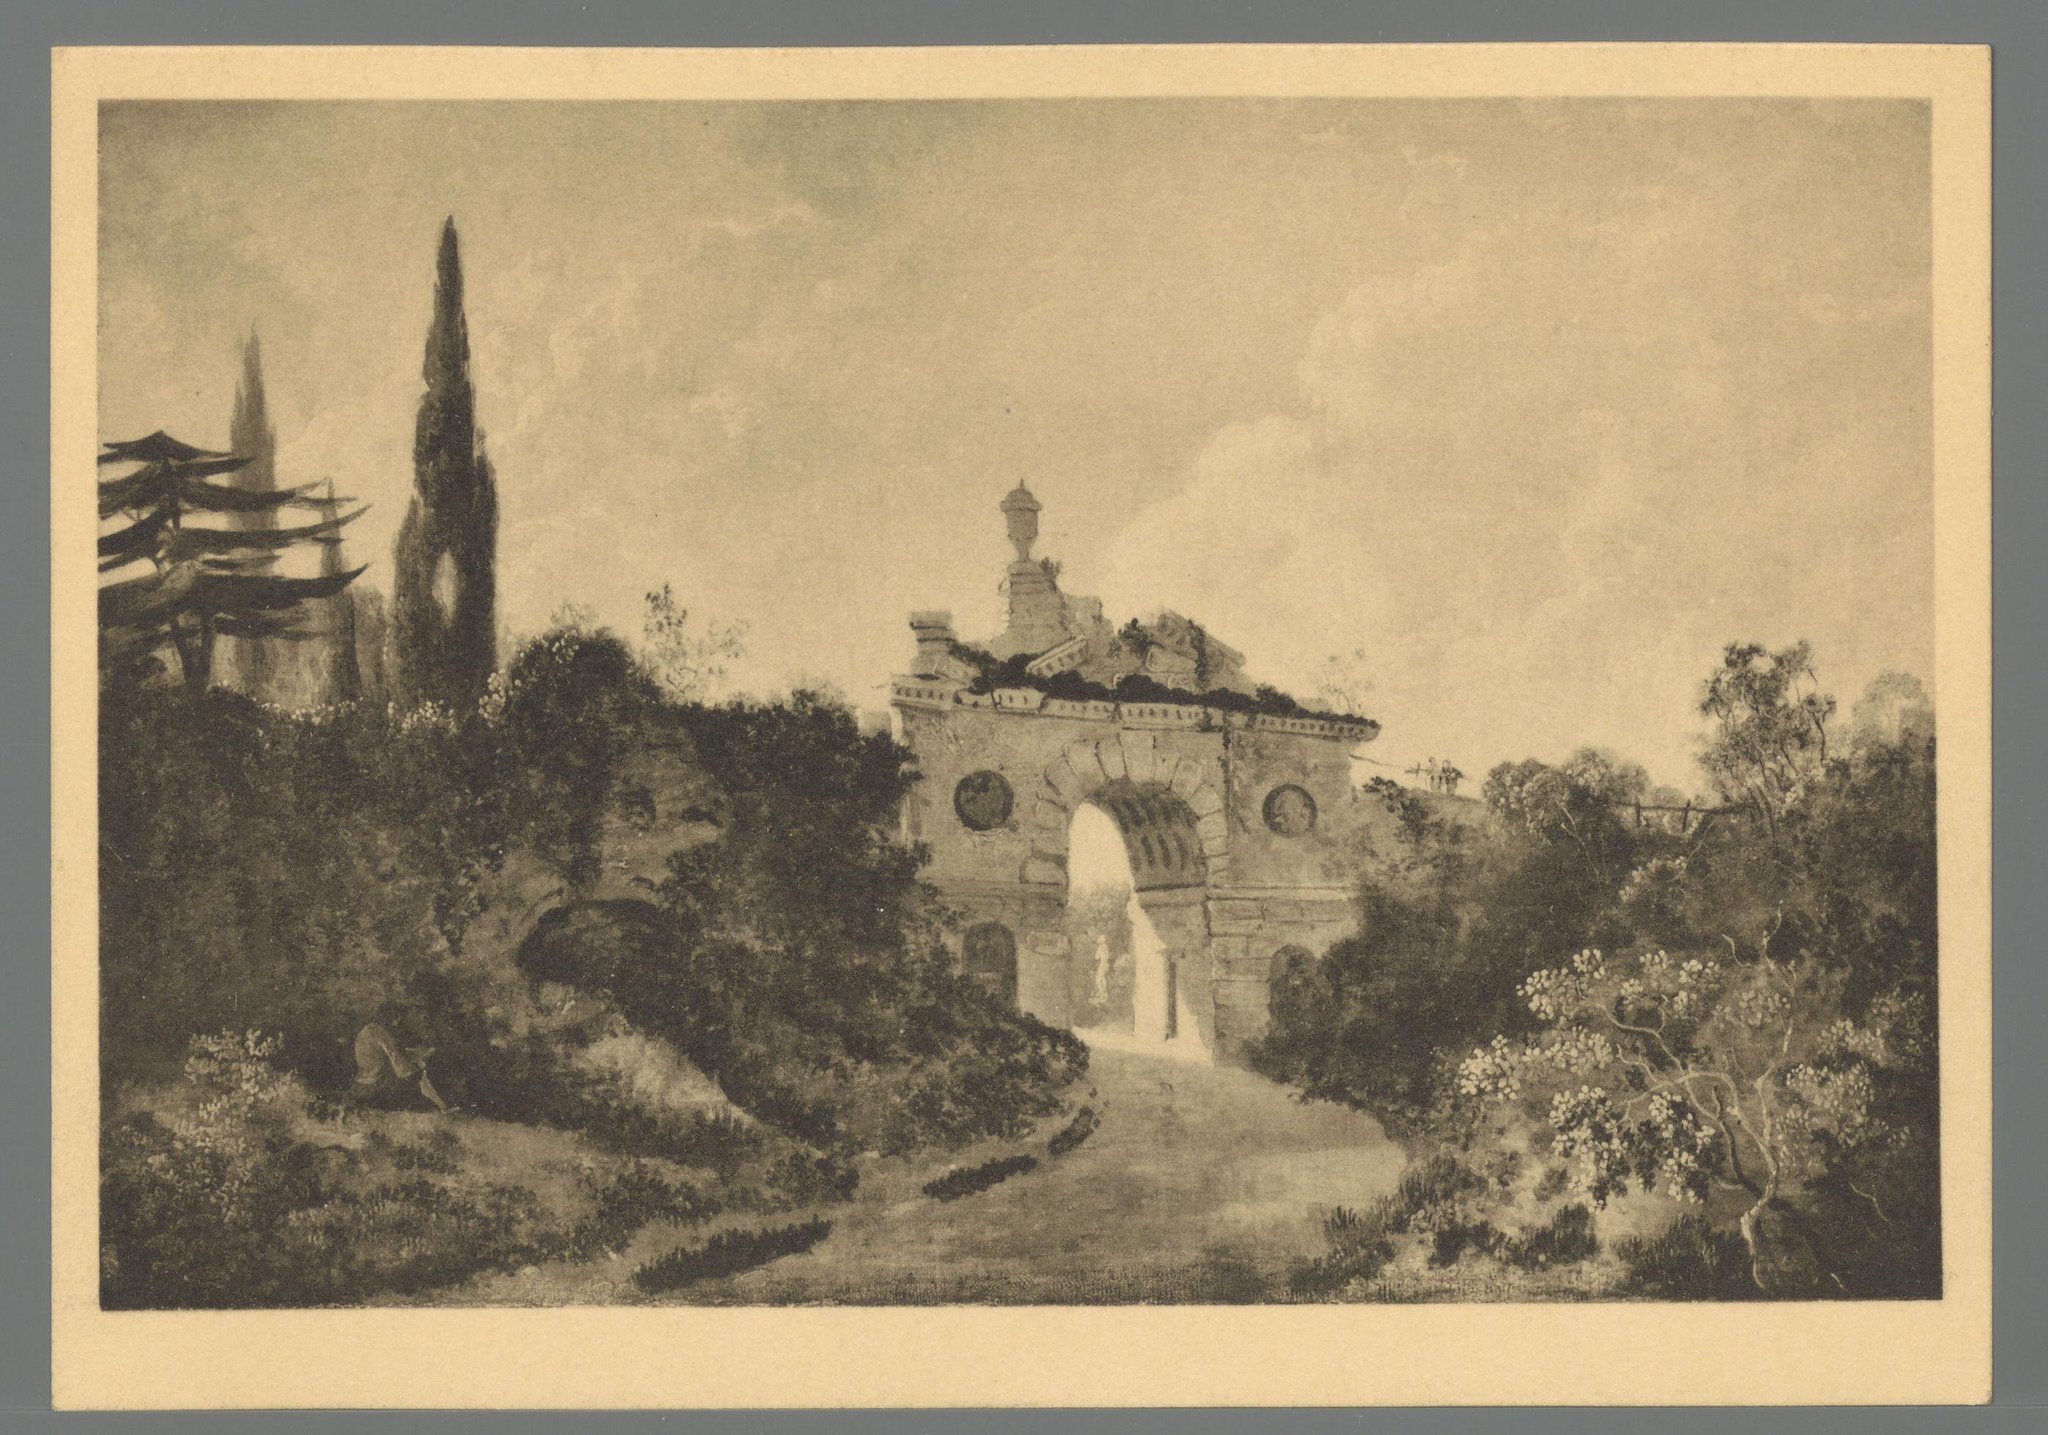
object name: photomechanical print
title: Richard Wilson. "Villa Borghese". Eig. Captain Richard Ford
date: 1936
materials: cardboard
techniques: photograph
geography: amsterdam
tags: park, gate, entrance